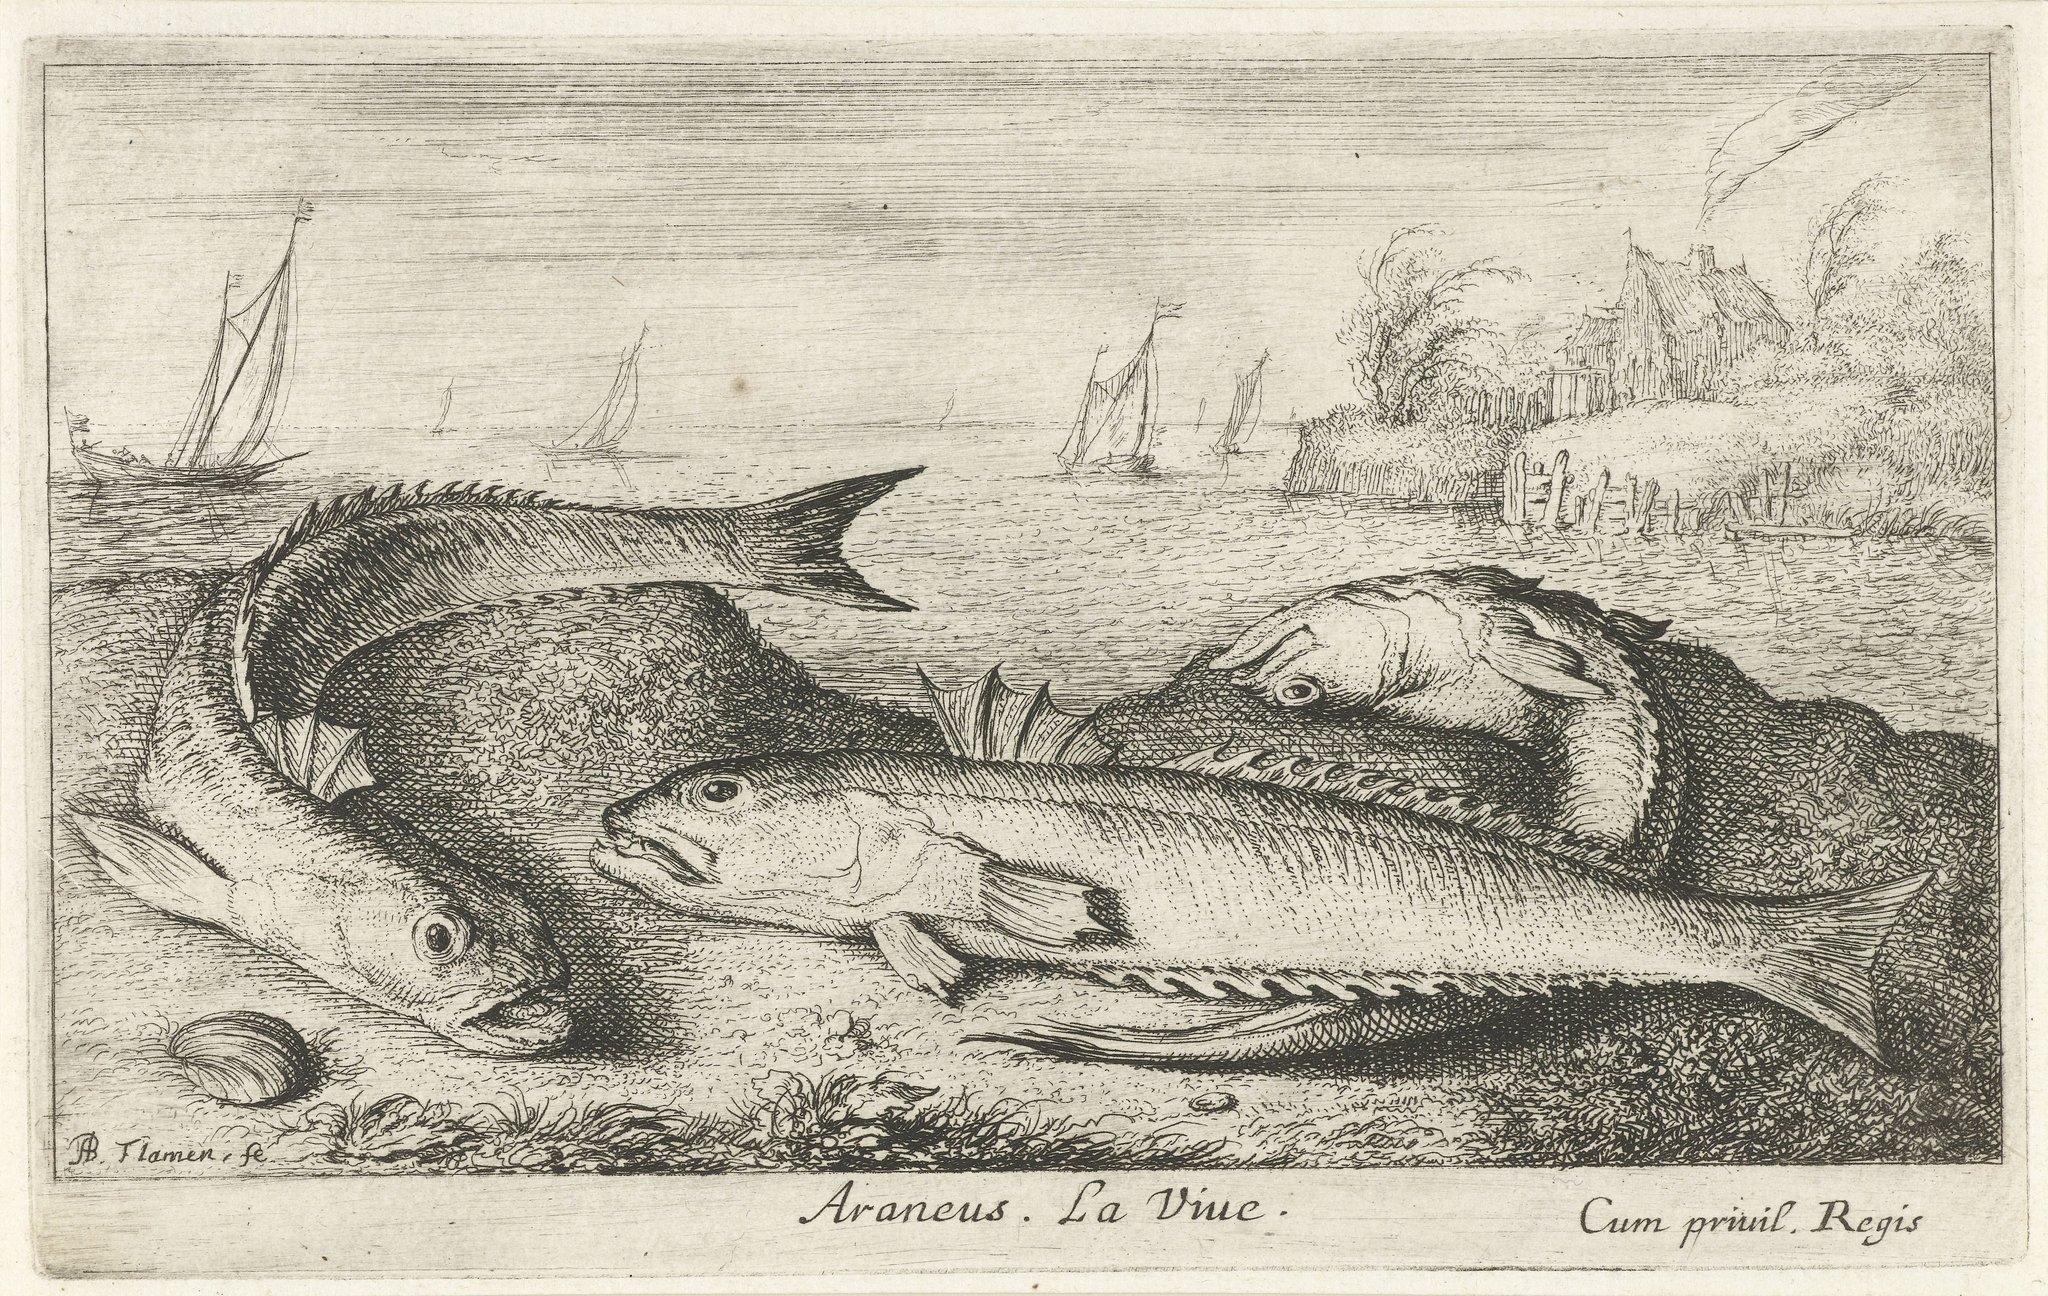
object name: print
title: Drie gevlekte pietermannen op het strand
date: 1664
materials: paper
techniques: etching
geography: paris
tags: bony fishes: weever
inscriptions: collector's mark: Lugt 2228